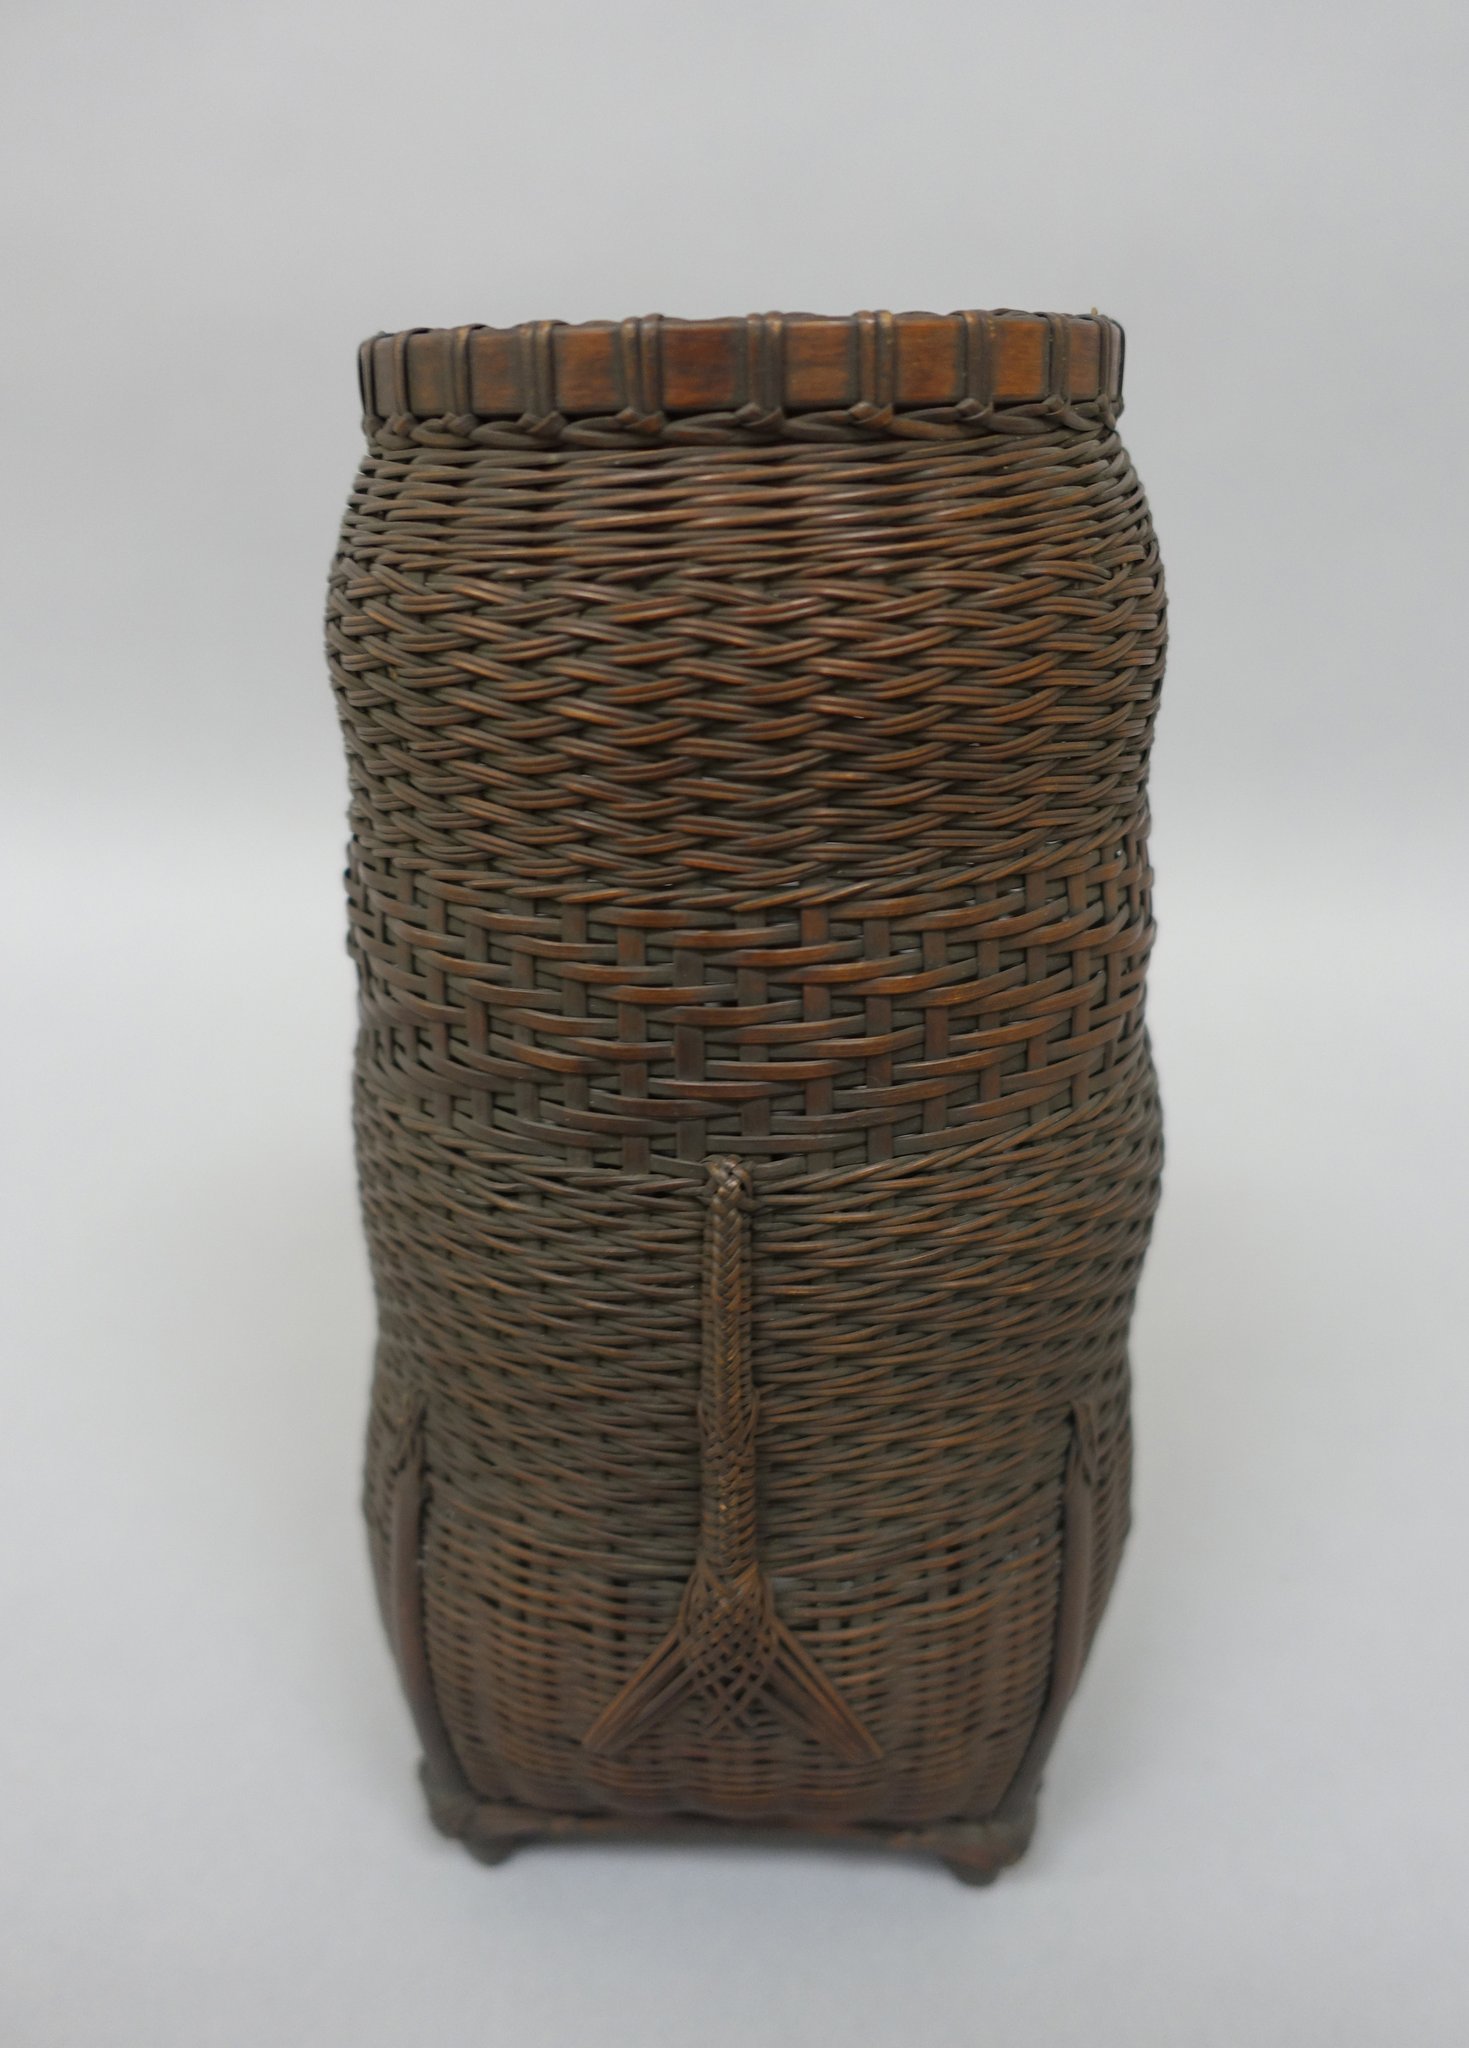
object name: basket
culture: japanese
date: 1801-1900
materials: bamboo